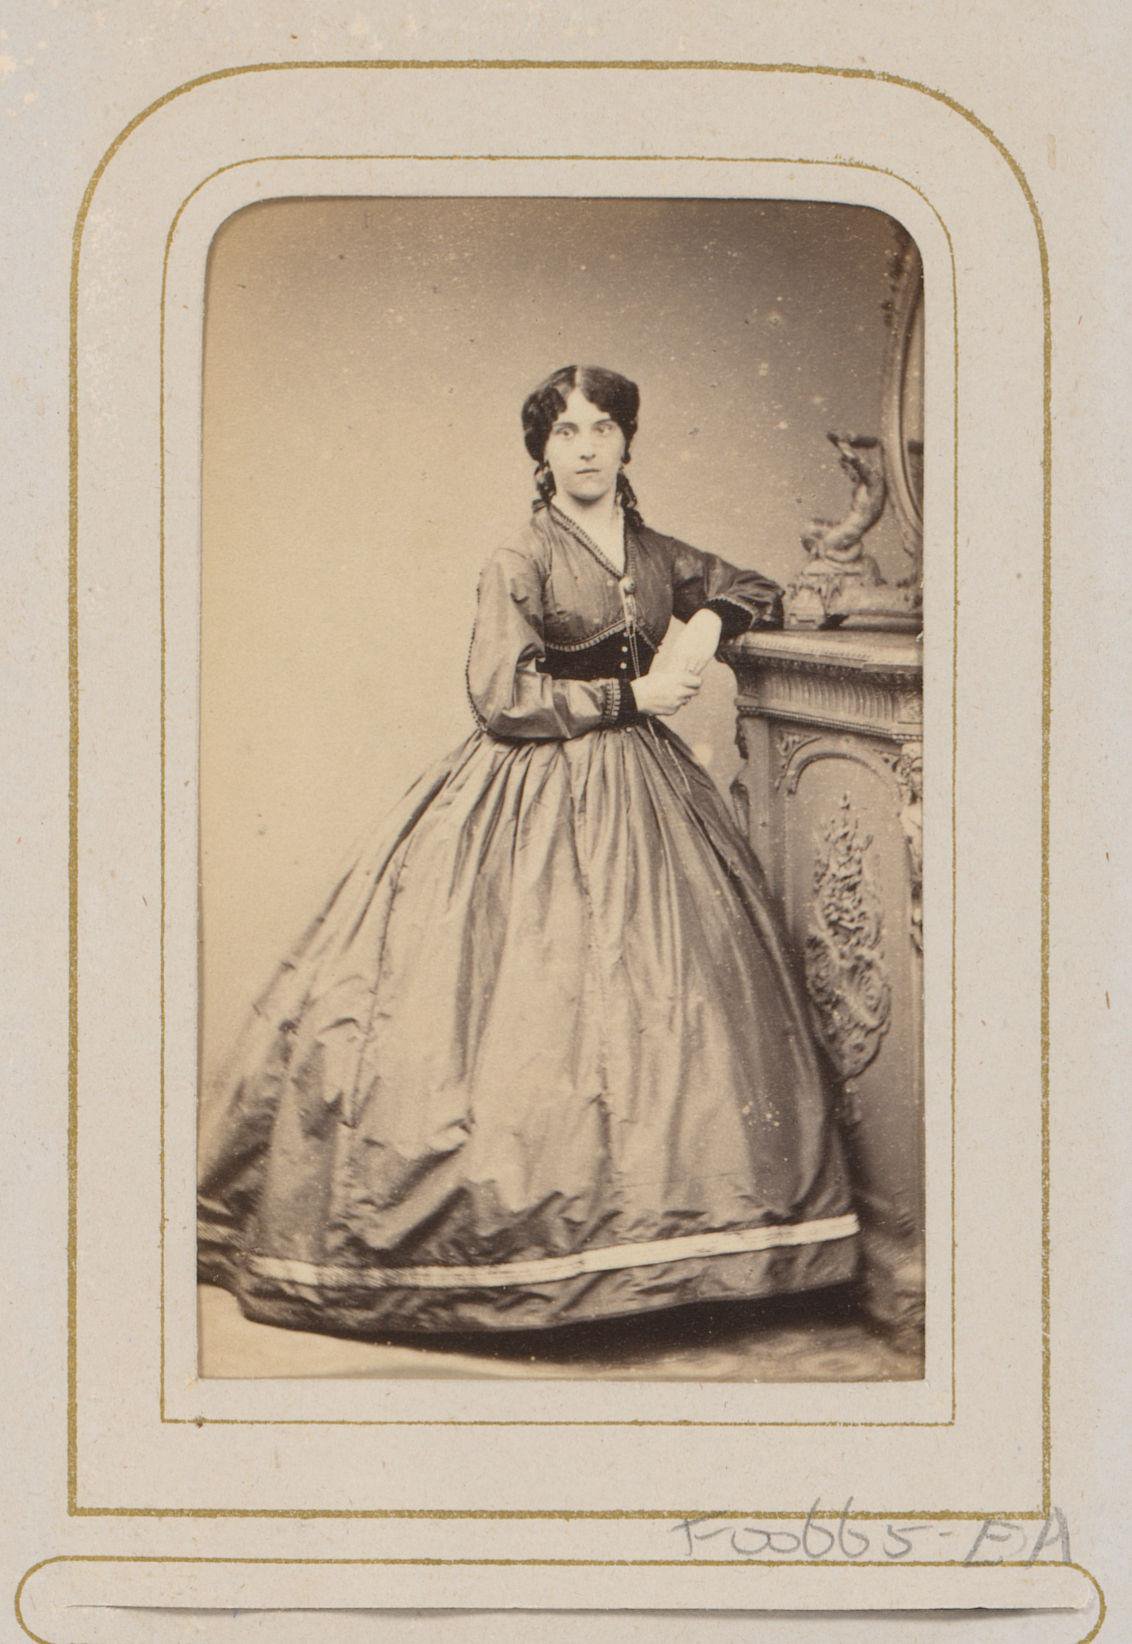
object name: carte de visite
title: Portret van een vrouw bij een spiegel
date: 1856-1865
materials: cardboard, photographic support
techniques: albumen print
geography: london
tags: historical persons - bb - woman, mirror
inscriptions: inscription: ‘Maul & Polyblank/ Photographers/ 55, Gracechurch street/ 187a, Piccadilly/ and Tavistock House Fulham Road/ London’